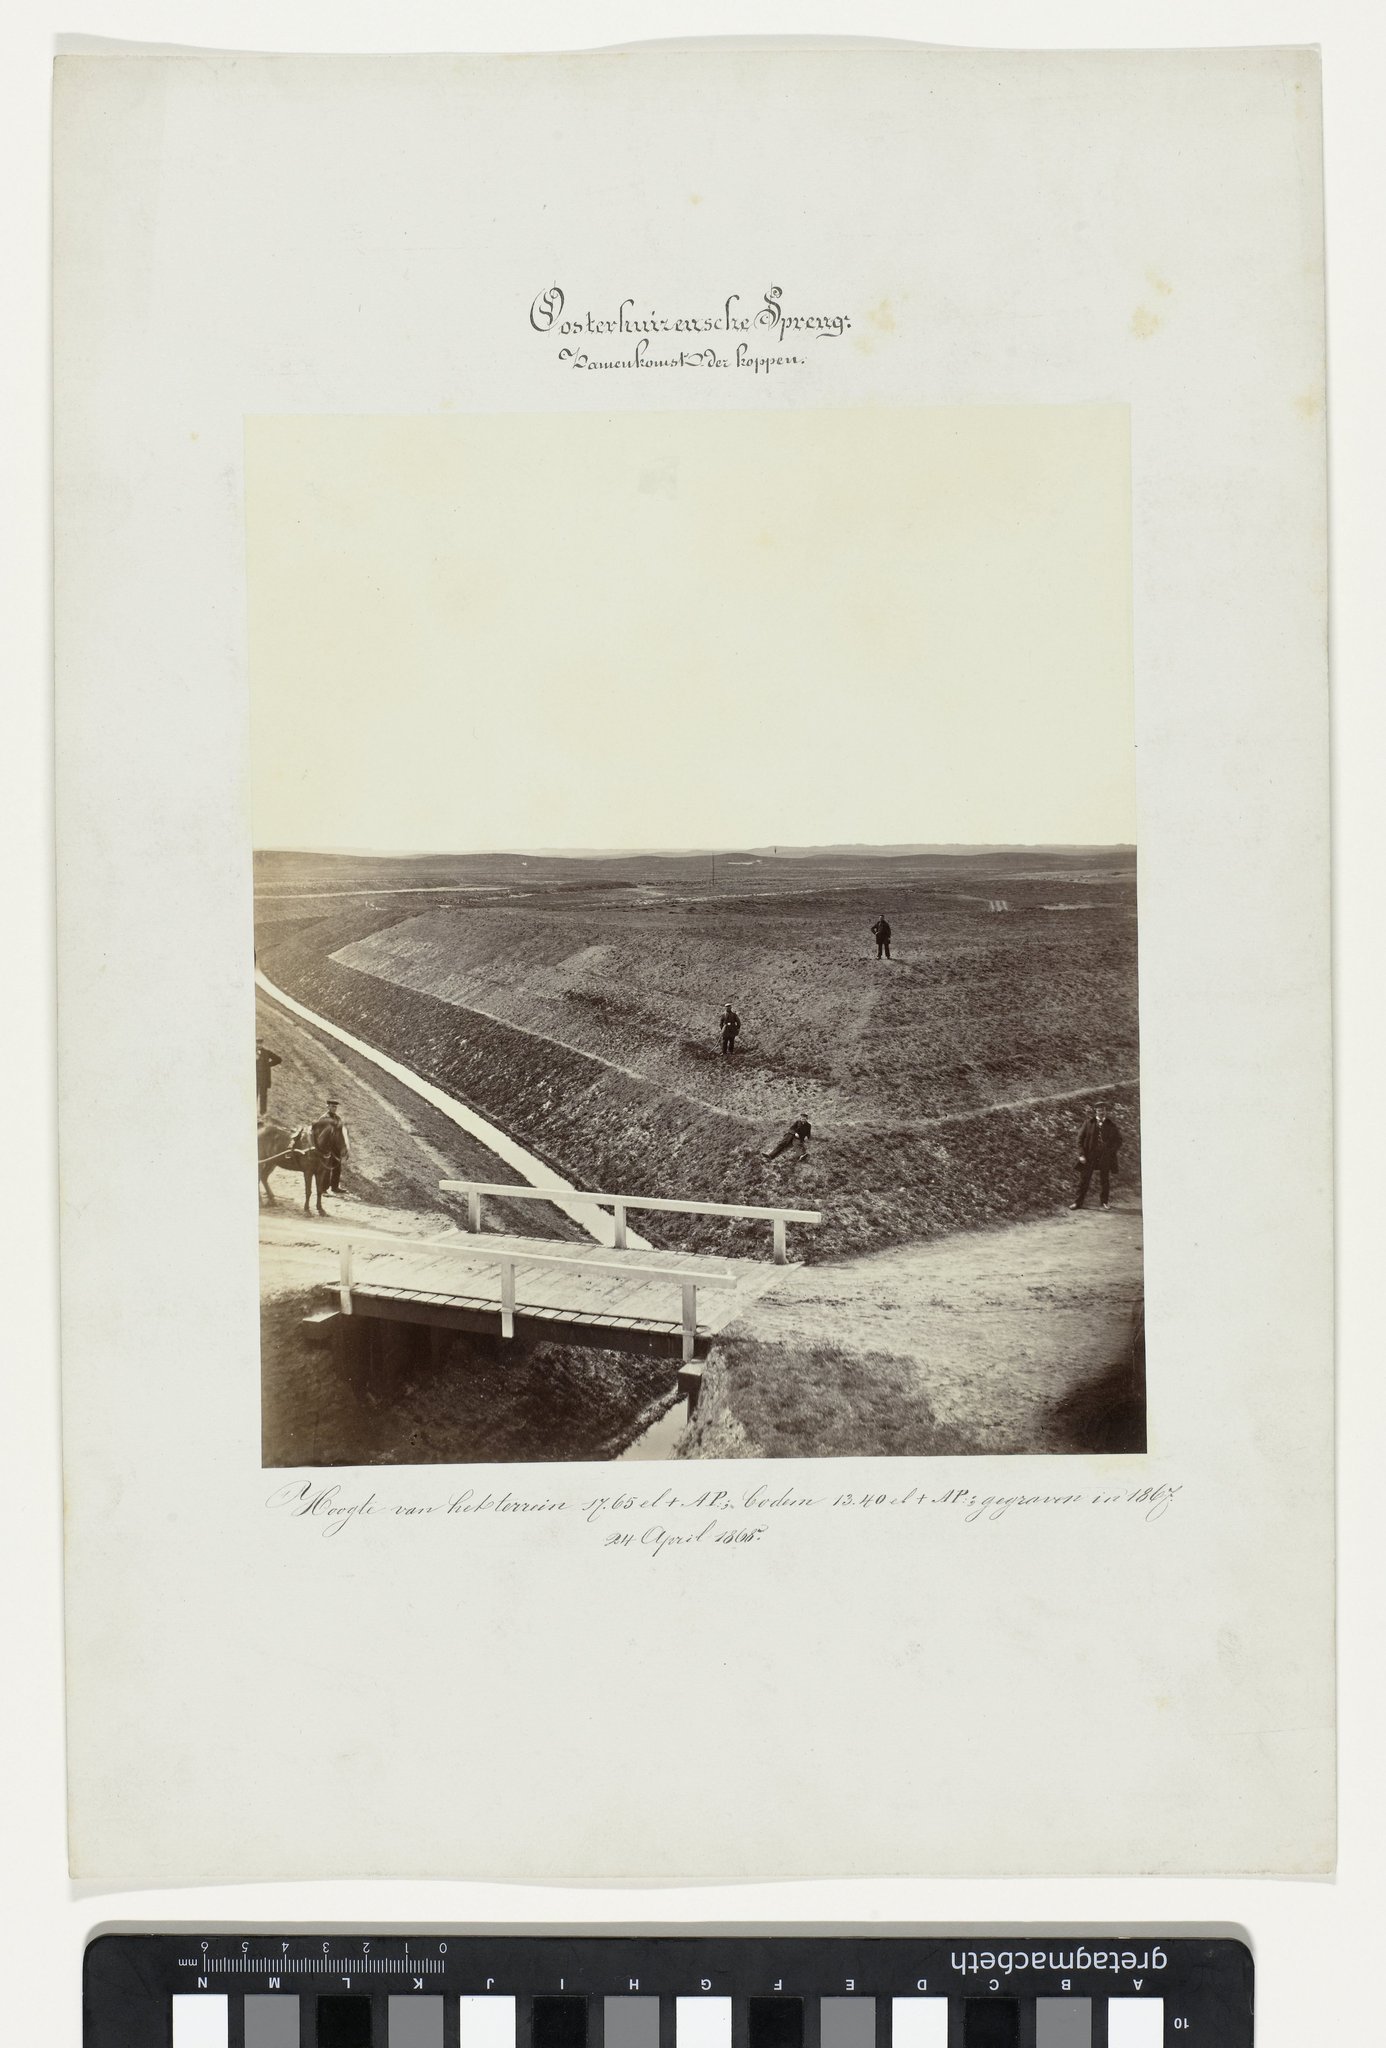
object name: photograph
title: Oosterhuizensche Spreng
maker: Anonymous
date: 1868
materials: cardboard, paper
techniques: photography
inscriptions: date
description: Foto op karton, van waterbouwkundige werken. Gedateerd.